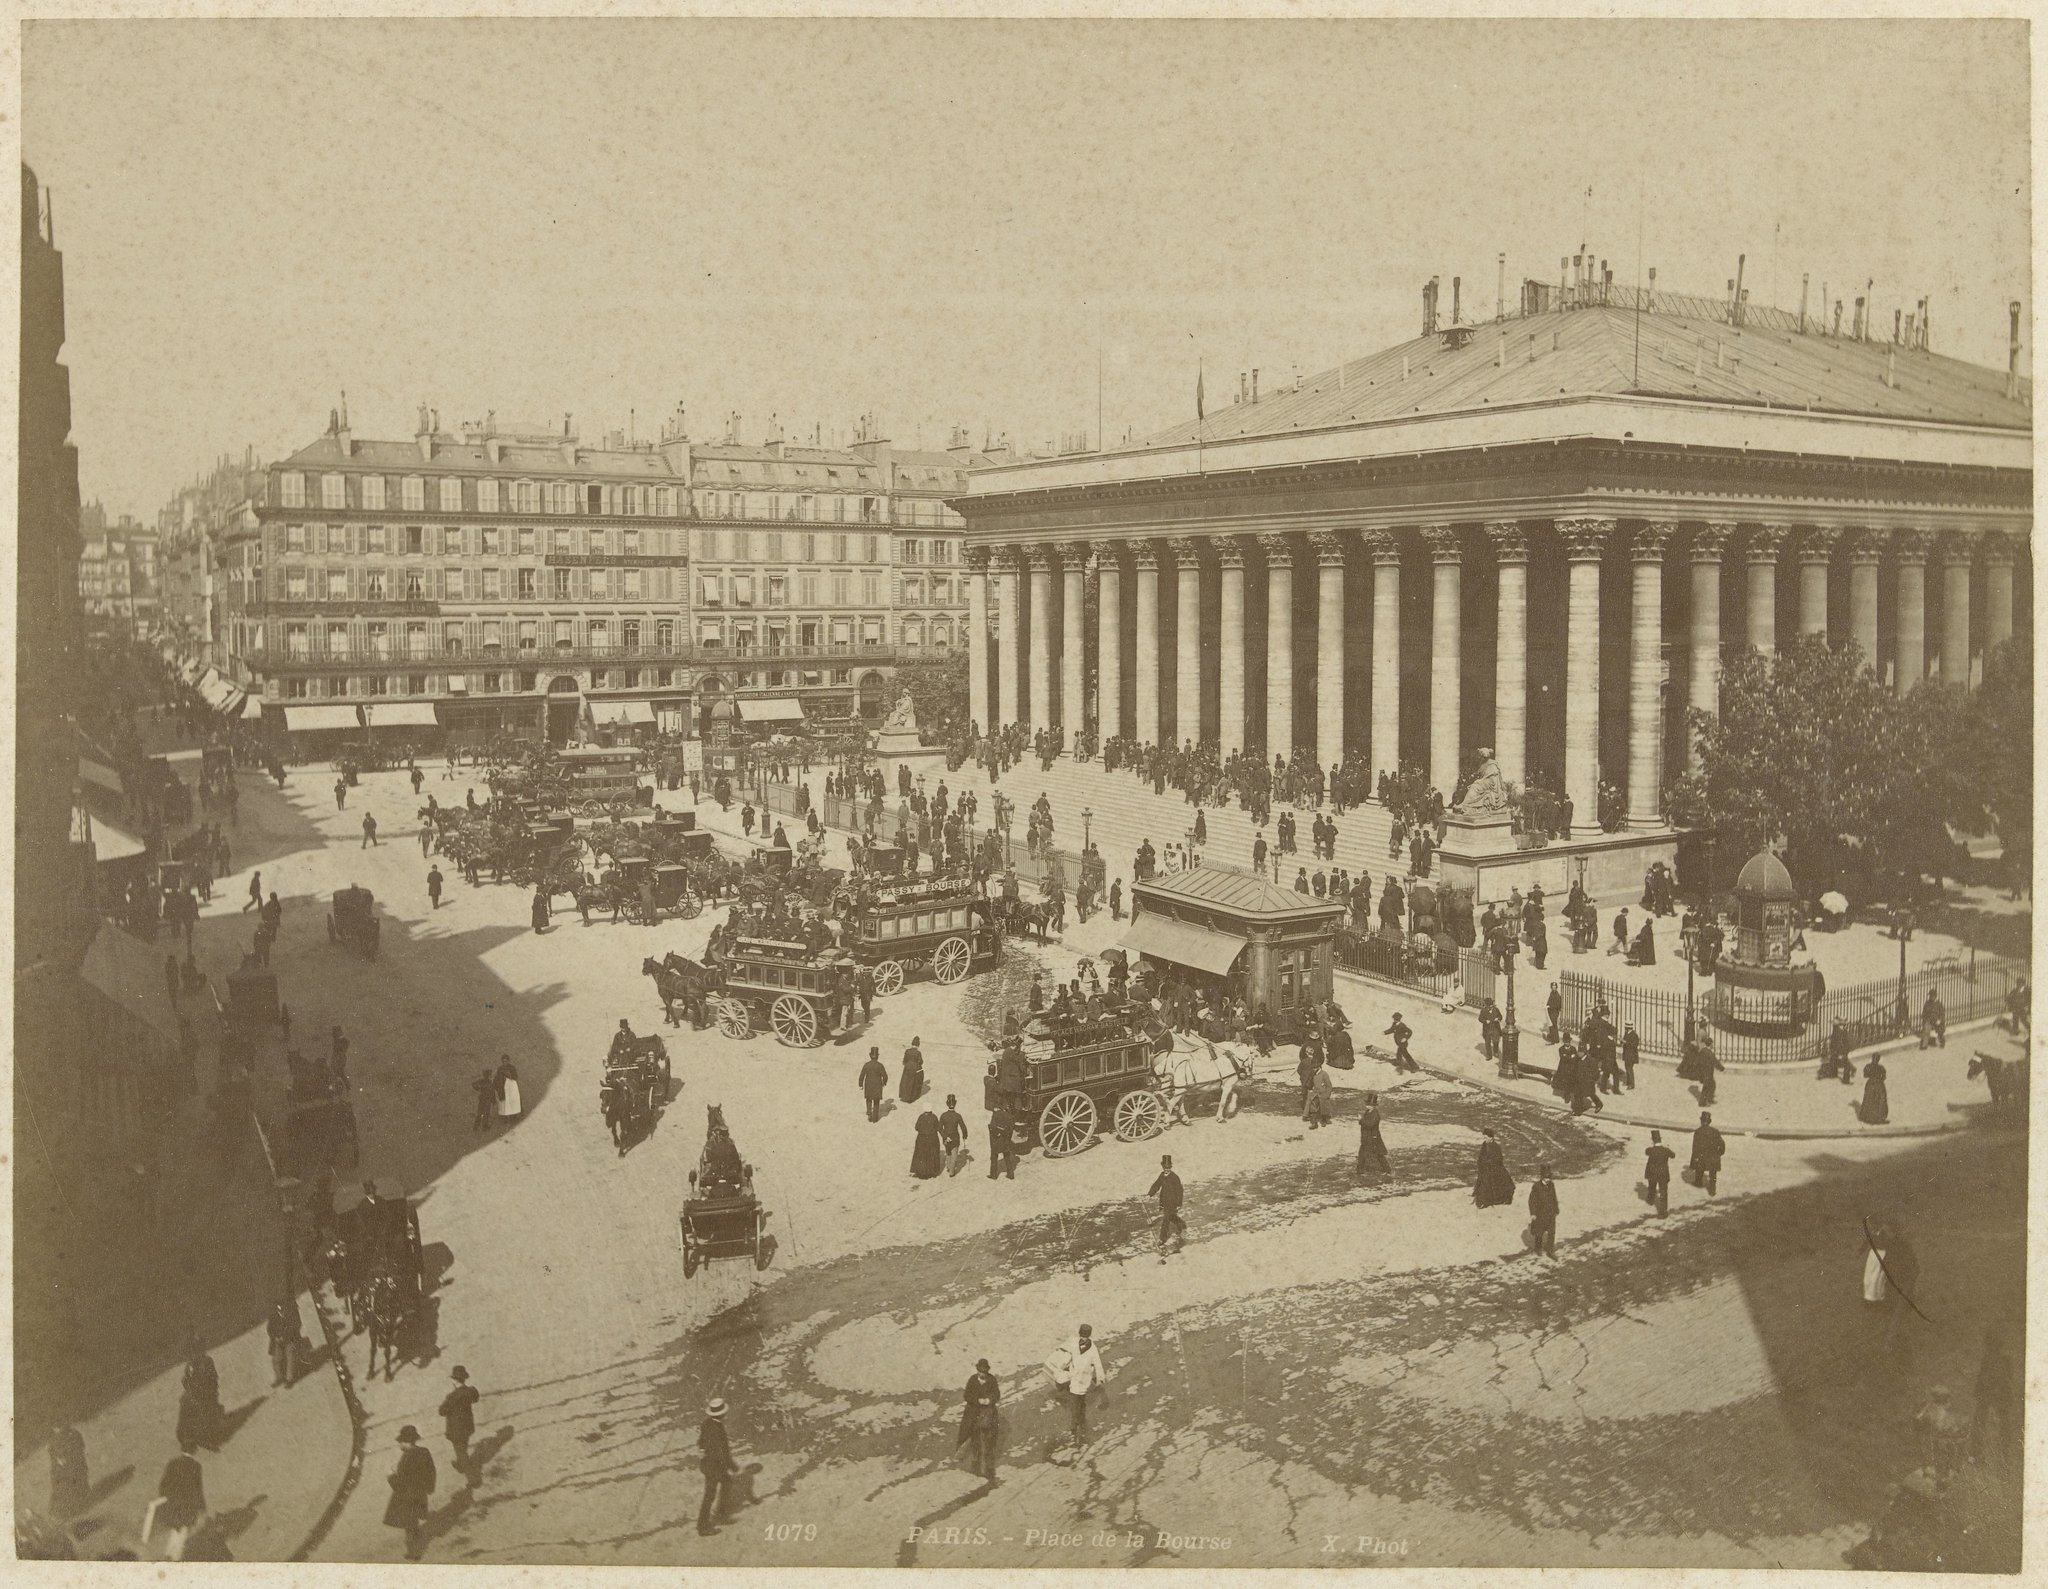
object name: photograph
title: Gezicht op het Place de la Bourse te Parijs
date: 1887-1900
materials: paper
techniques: albumen print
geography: paris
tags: square, place, circus, etc., stock exchange, stock-market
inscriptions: inscription: ‘1079 Paris. - Place de la Bourse X. Phot.’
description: Tussen 1887 en ca. 1900 werkten Neurdein frères onder andere onder de naam 'X phot.'.